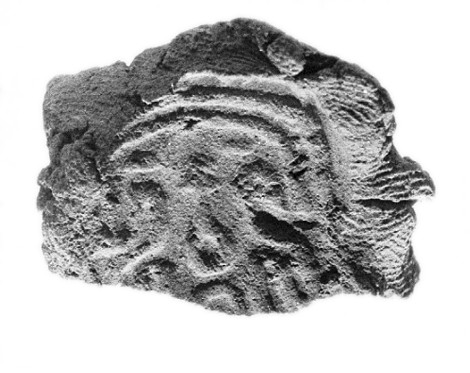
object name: sealing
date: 1981-1640 BCE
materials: mud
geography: egypt